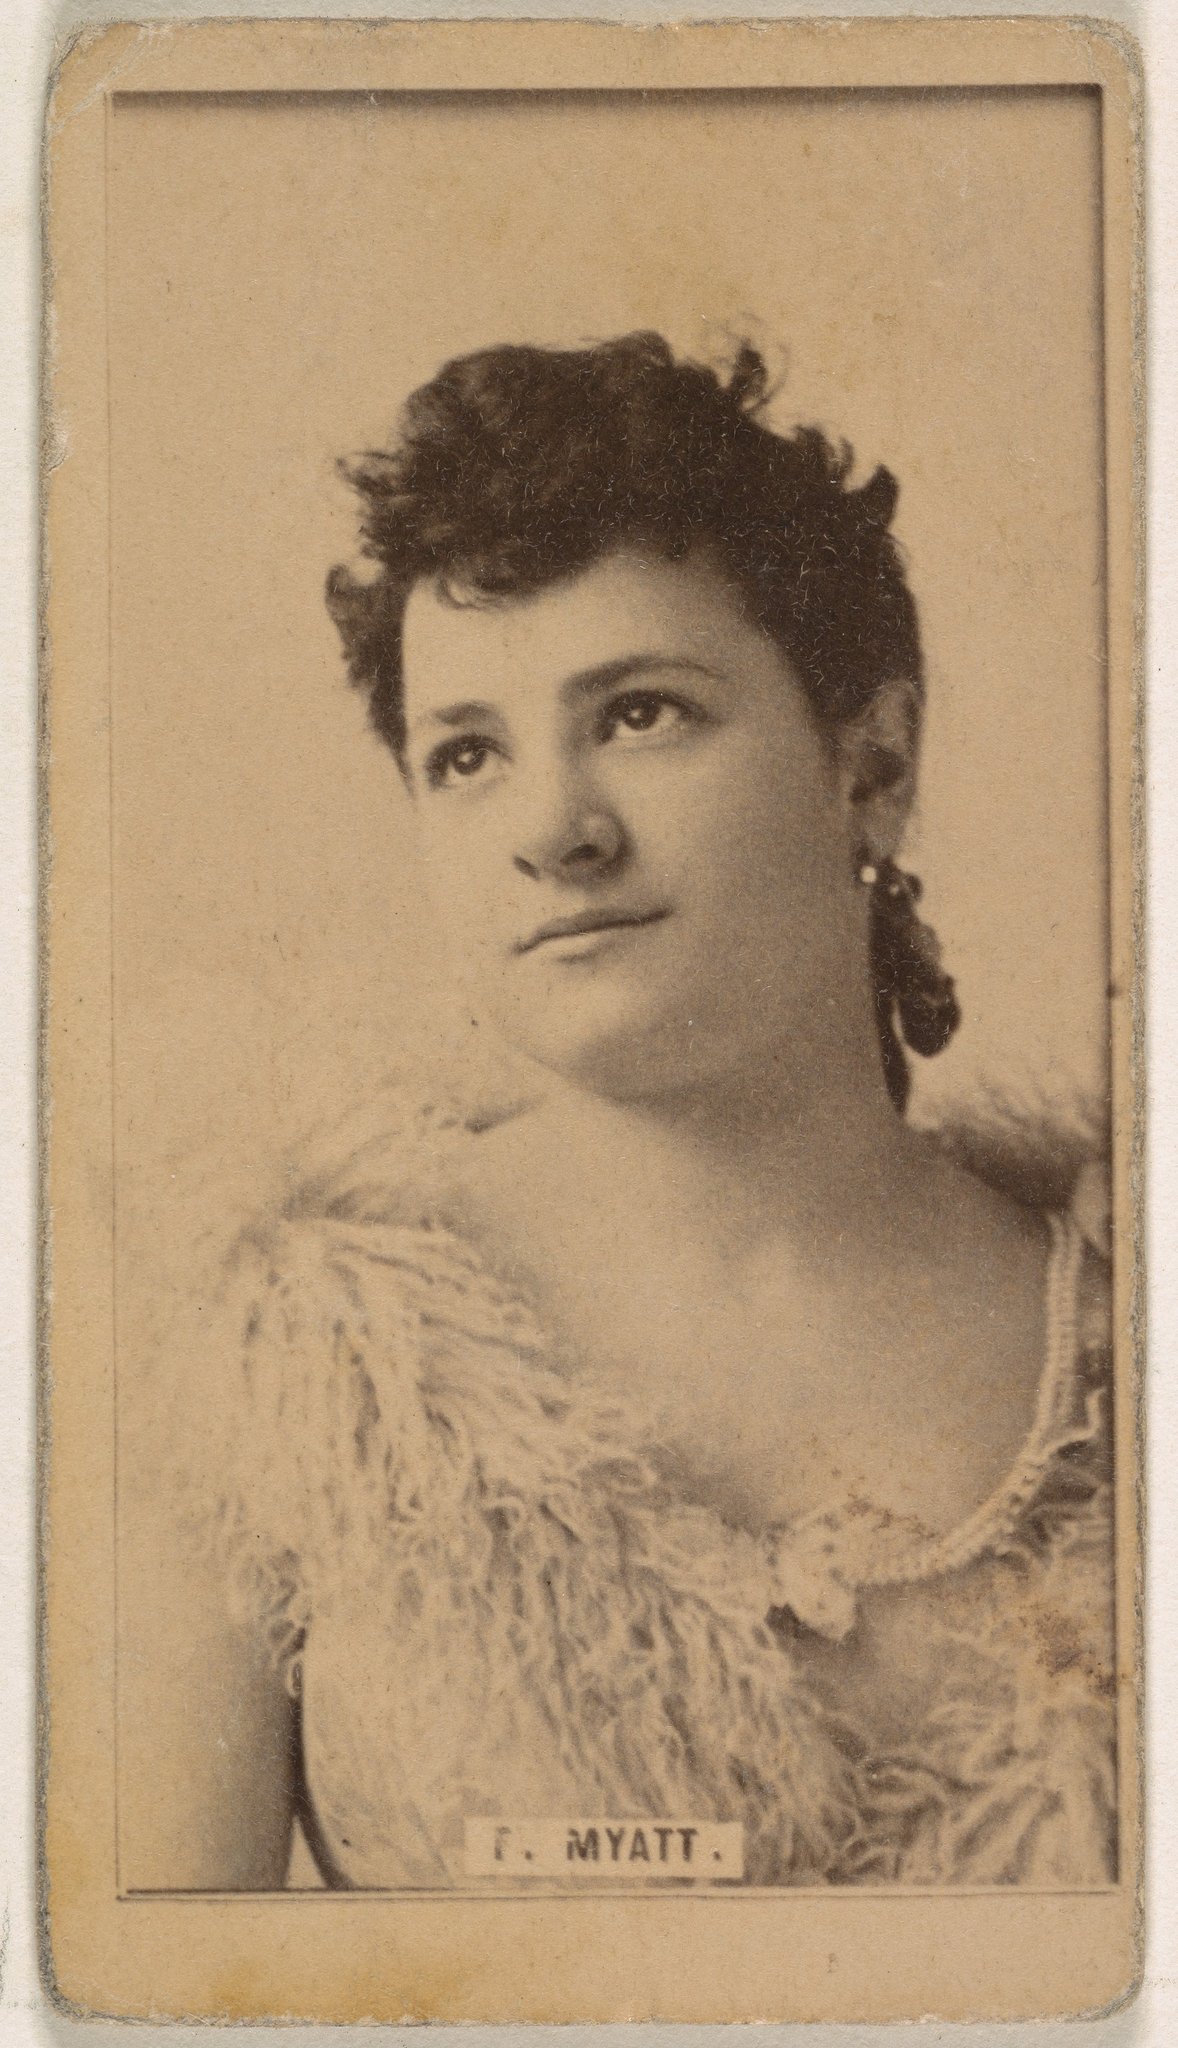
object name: photograph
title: Miss Myatt, from the Actresses series (N245) issued by Kinney Brothers to promote Sweet Caporal Cigarettes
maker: kinney brothers tobacco company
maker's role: publisher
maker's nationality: american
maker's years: 1869-2011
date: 1890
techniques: albumen silver print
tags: portraits,women,actresses